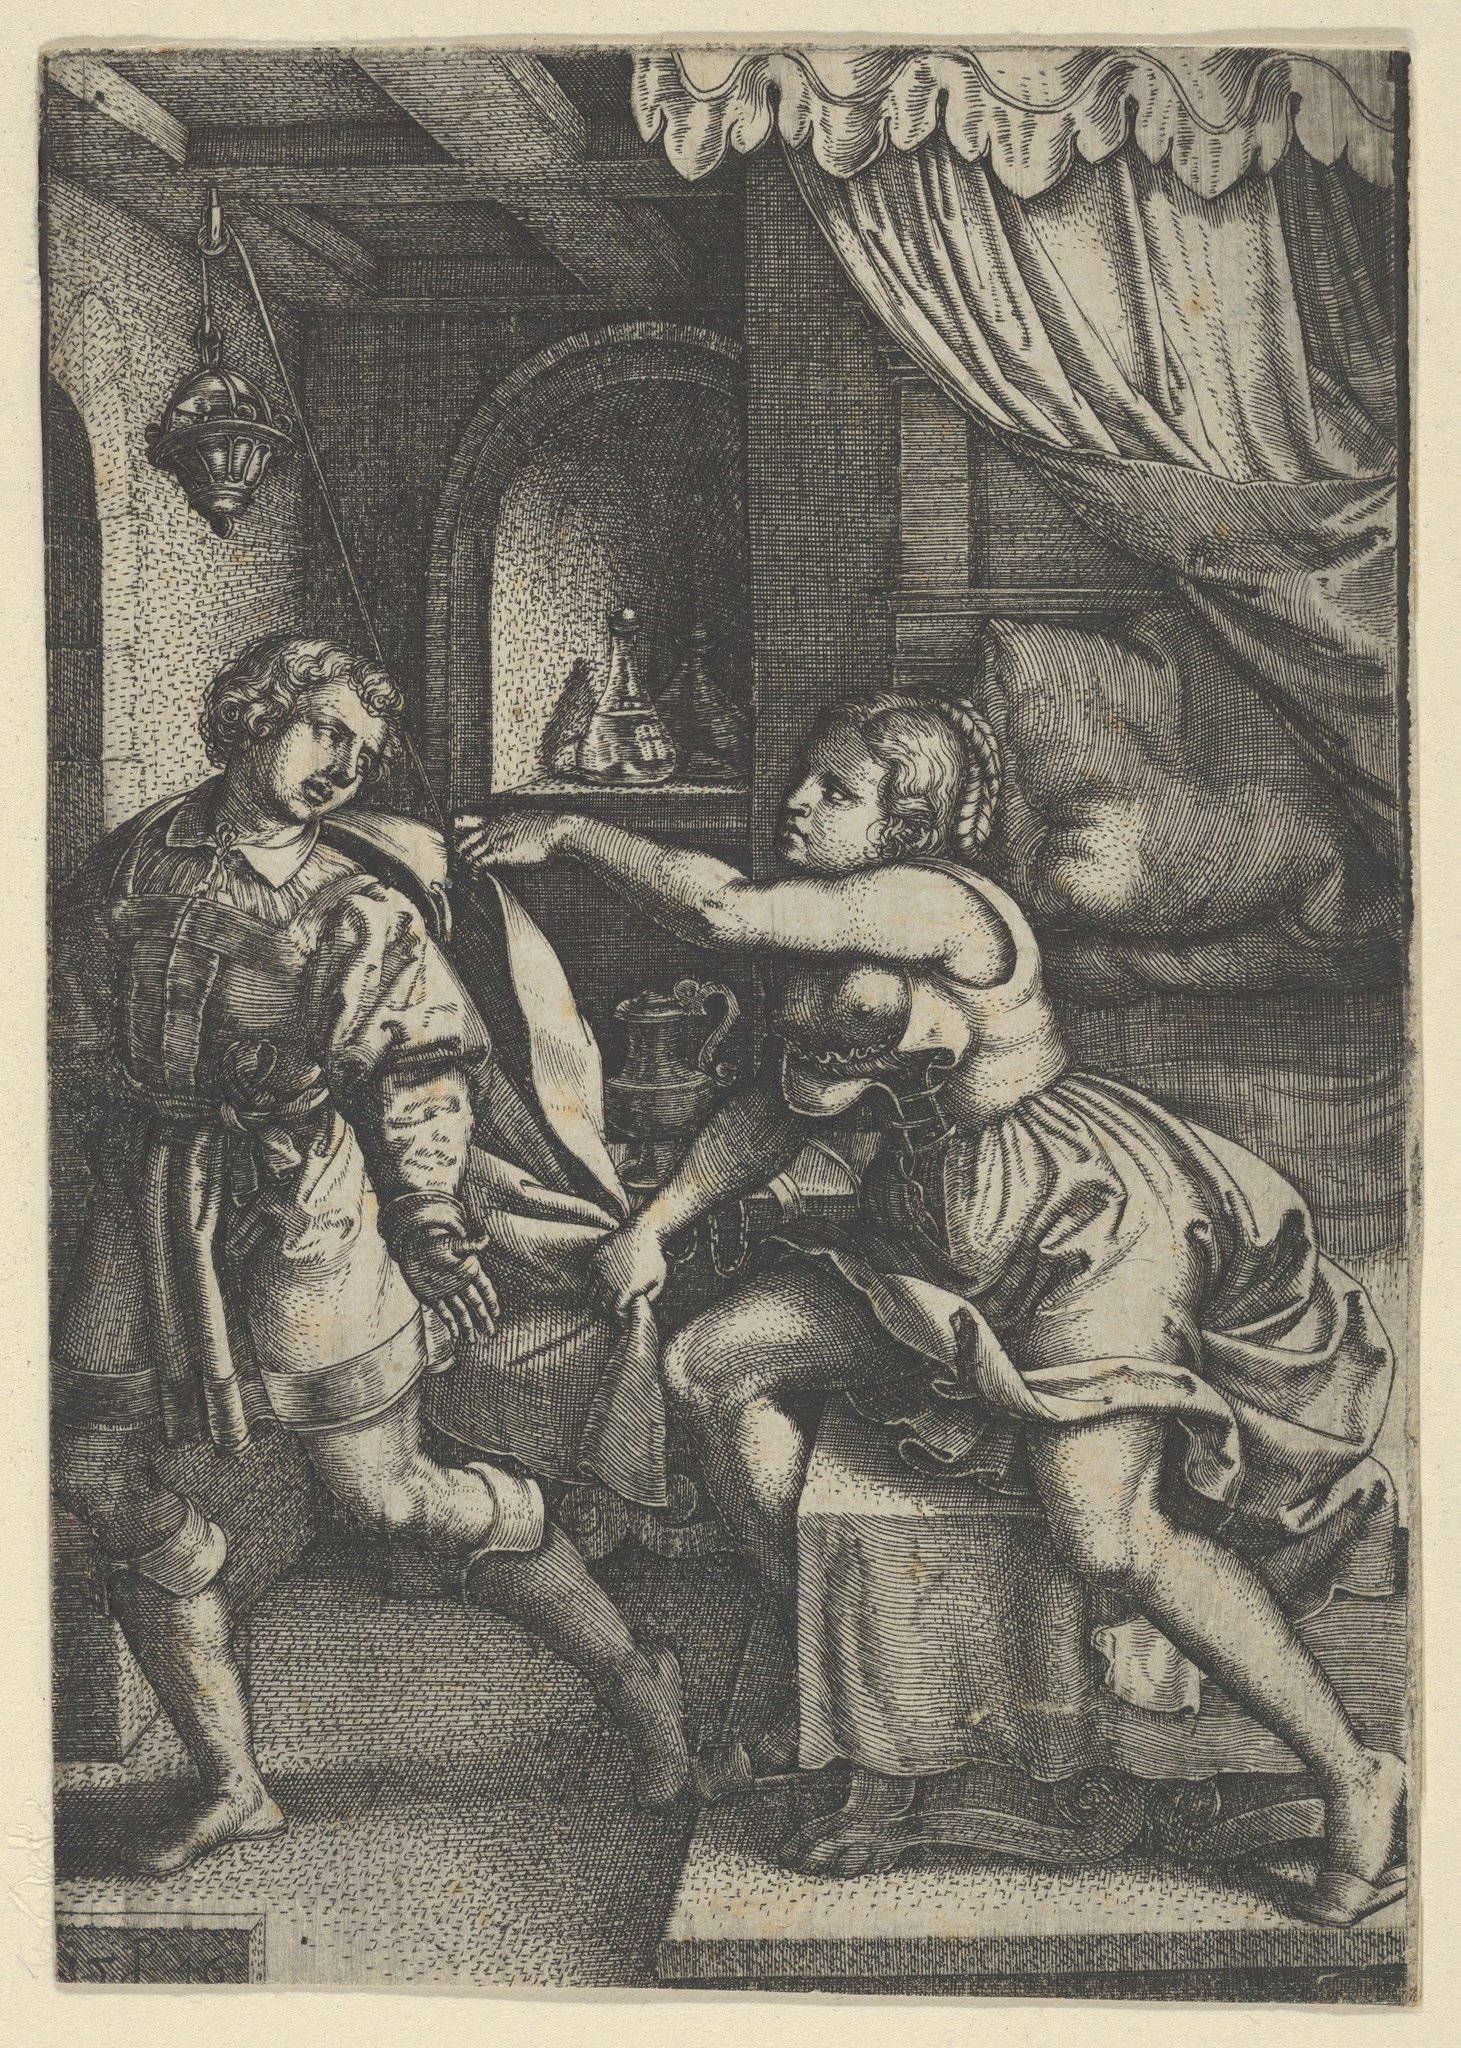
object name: print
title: Joseph and Potiphar's Wife, from The Story of Joseph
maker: georg pencz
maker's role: artist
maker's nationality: german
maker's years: 1500-1550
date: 1546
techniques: engraving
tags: bedrooms,men,women